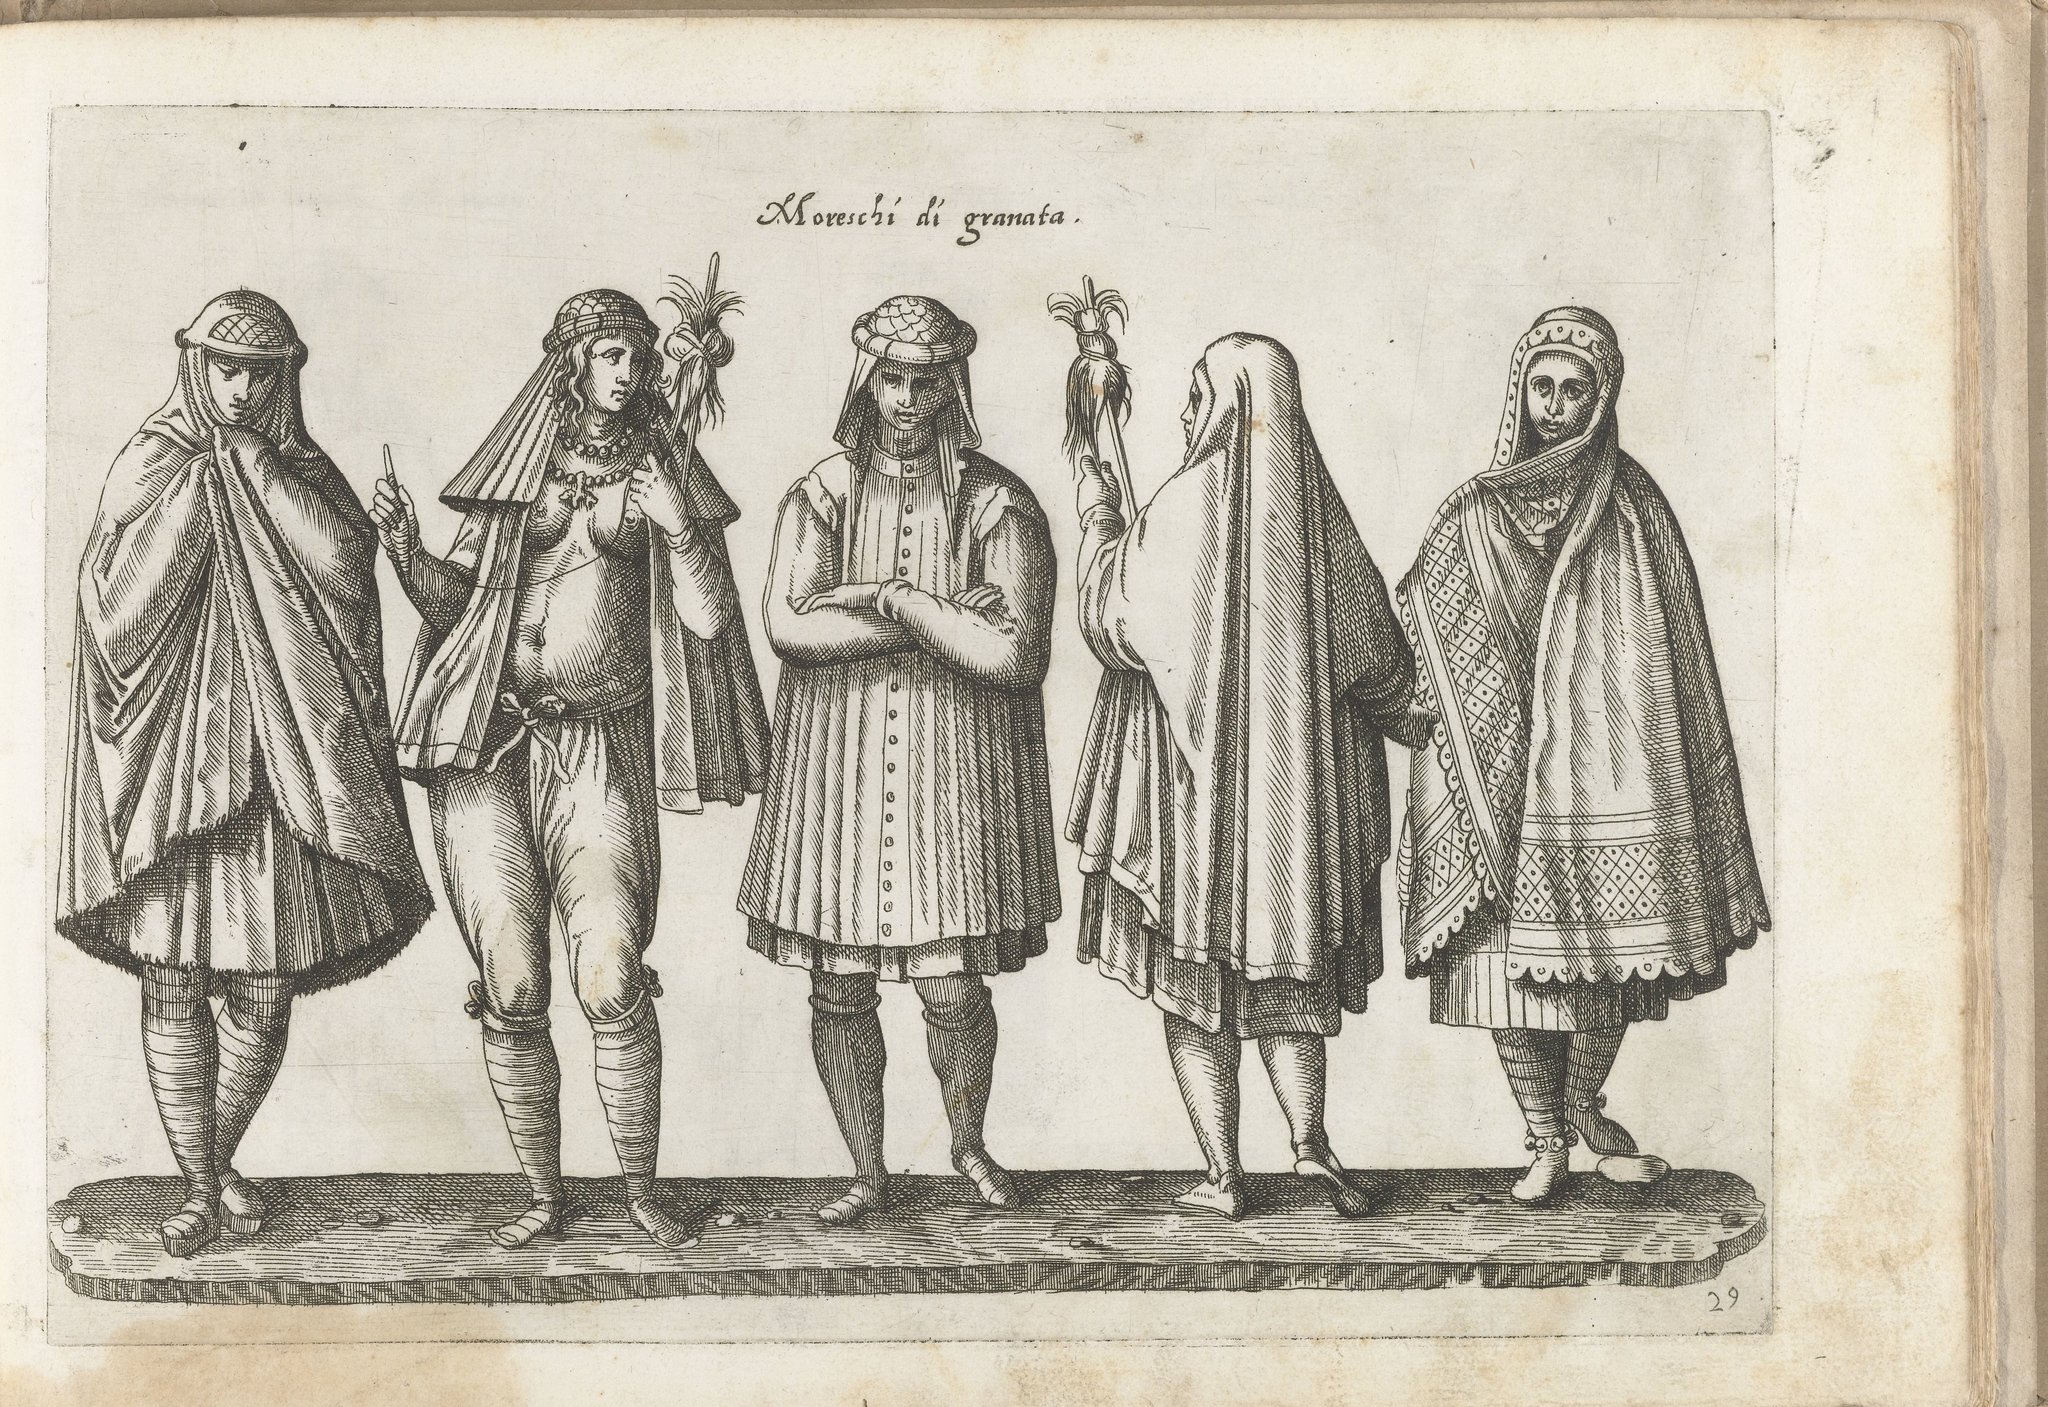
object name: costume print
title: Moreschi di granata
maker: bartolomeo grassi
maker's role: publisher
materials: paper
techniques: engraving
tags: europeans: spaniards (+ costume), spindle, clothes, costume (+ men's clothes)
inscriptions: number: ‘28’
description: Prent nr. 29 uit album 'Dei veri ritratti degl'habiti di tvtte le parti del mondo intagliati in rame per opra di Bartolomeo Grassi', 1585.